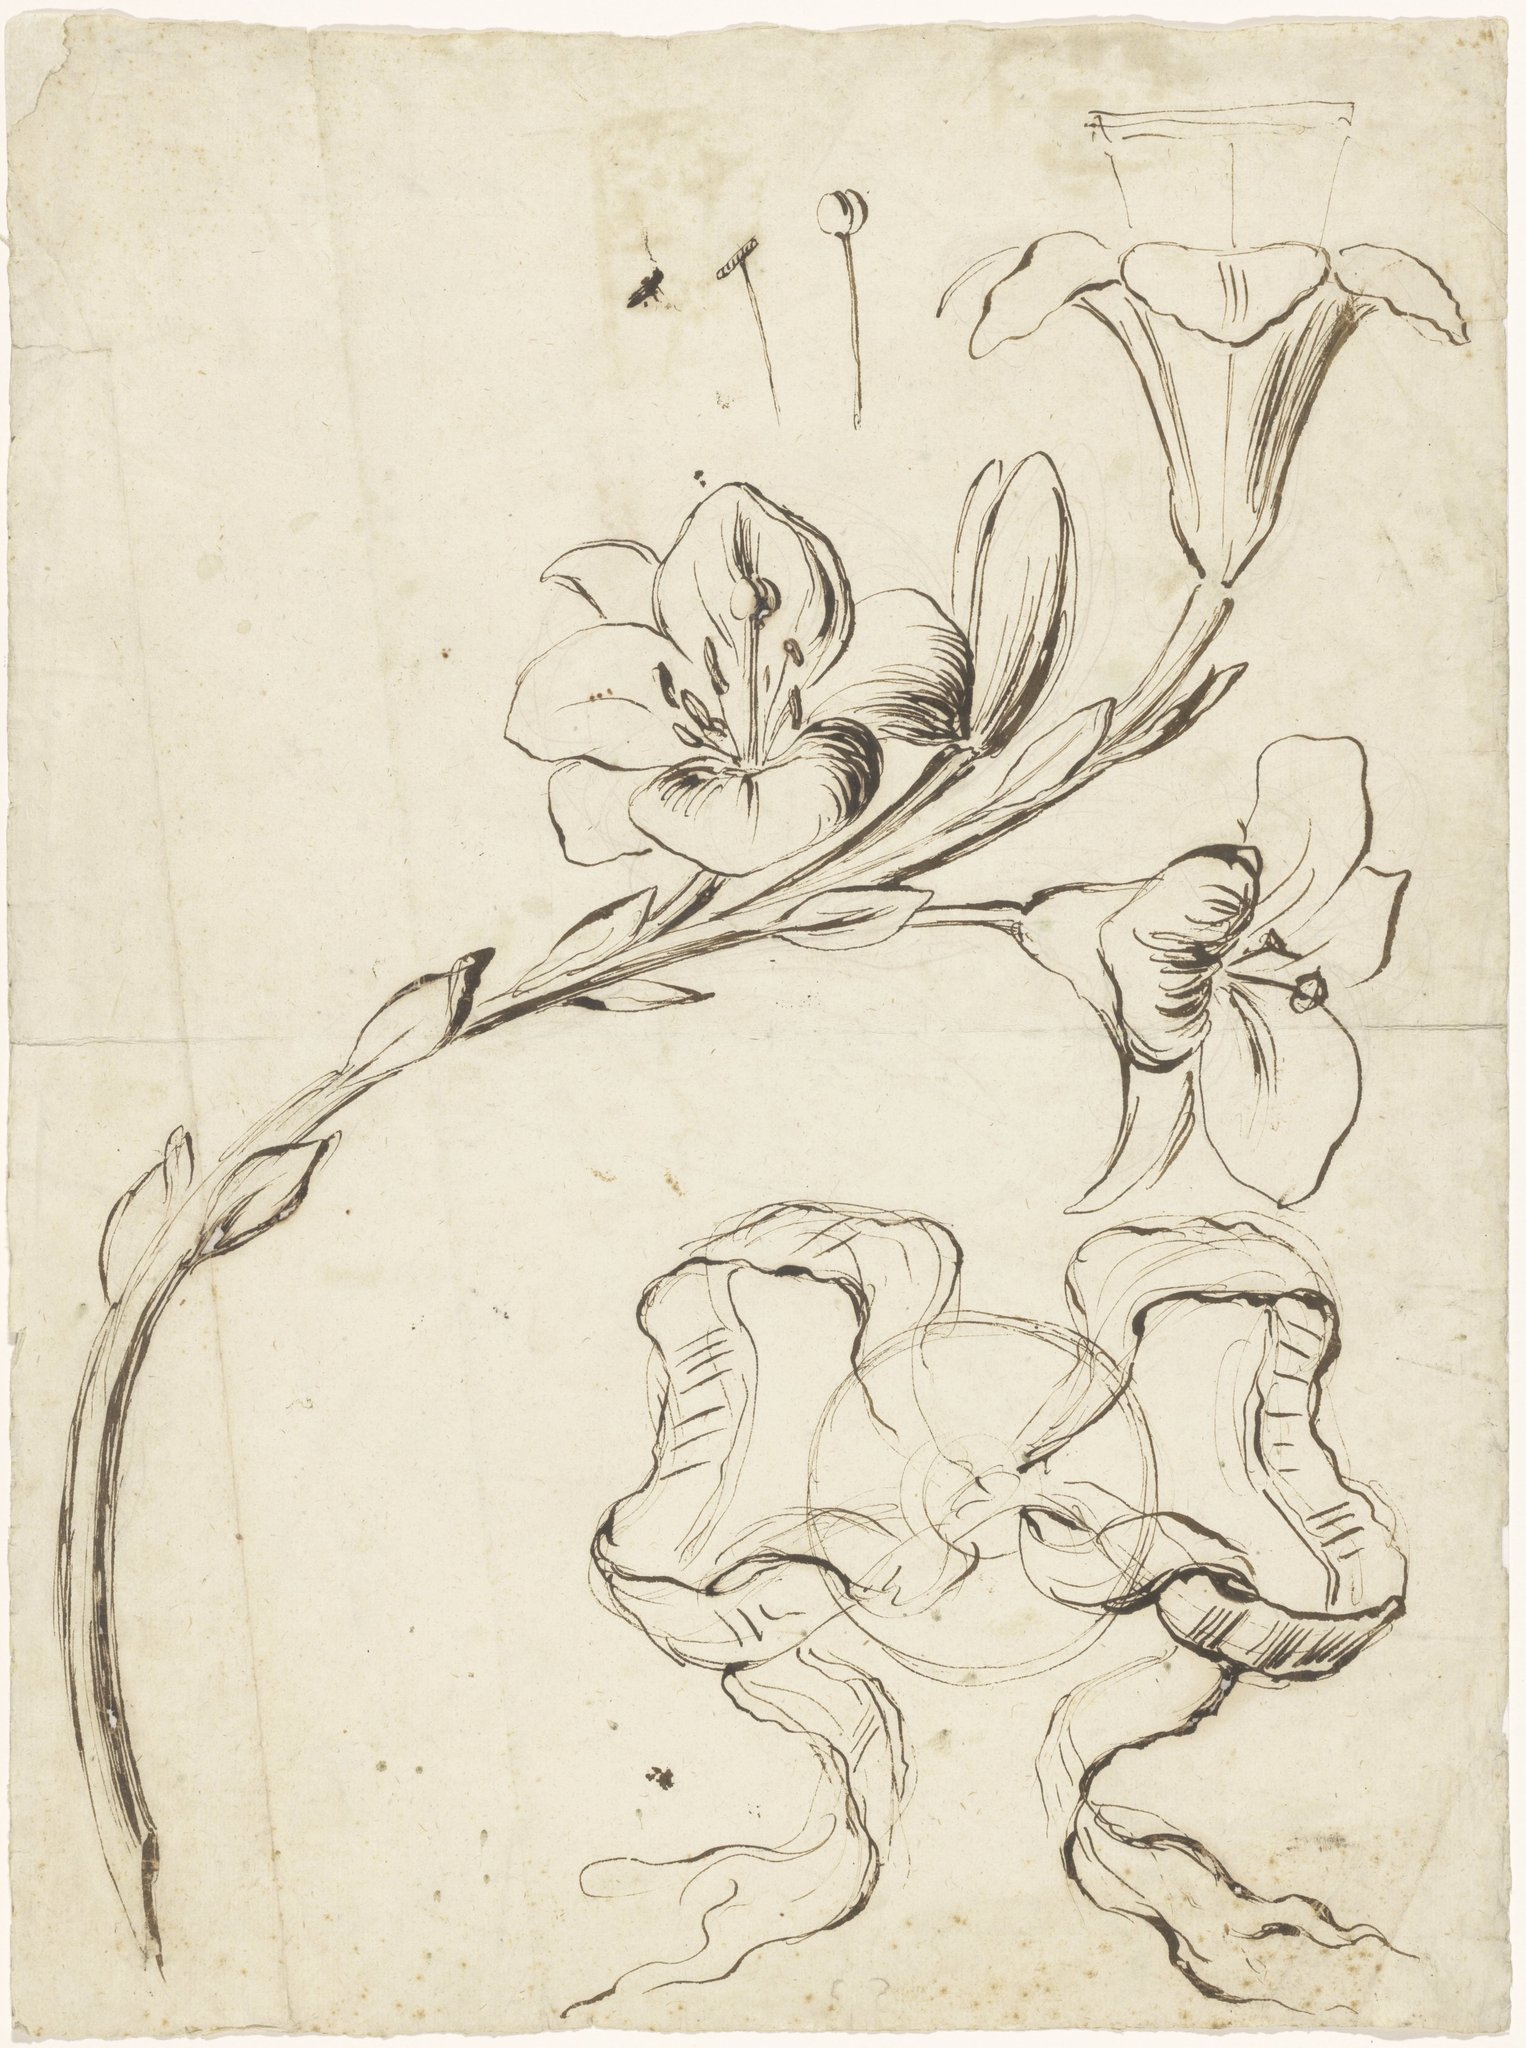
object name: design drawing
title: Ontwerp voor de arm van een wandarm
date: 1775-1790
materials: graphite, paper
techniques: pen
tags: sconce, wall lamp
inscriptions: watermark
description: Ontwerp voor de arm van een wandarm in de vorm van een tak met drie lelies, een achterplaat (?) met een strik en enkele spijkers of pinnen.